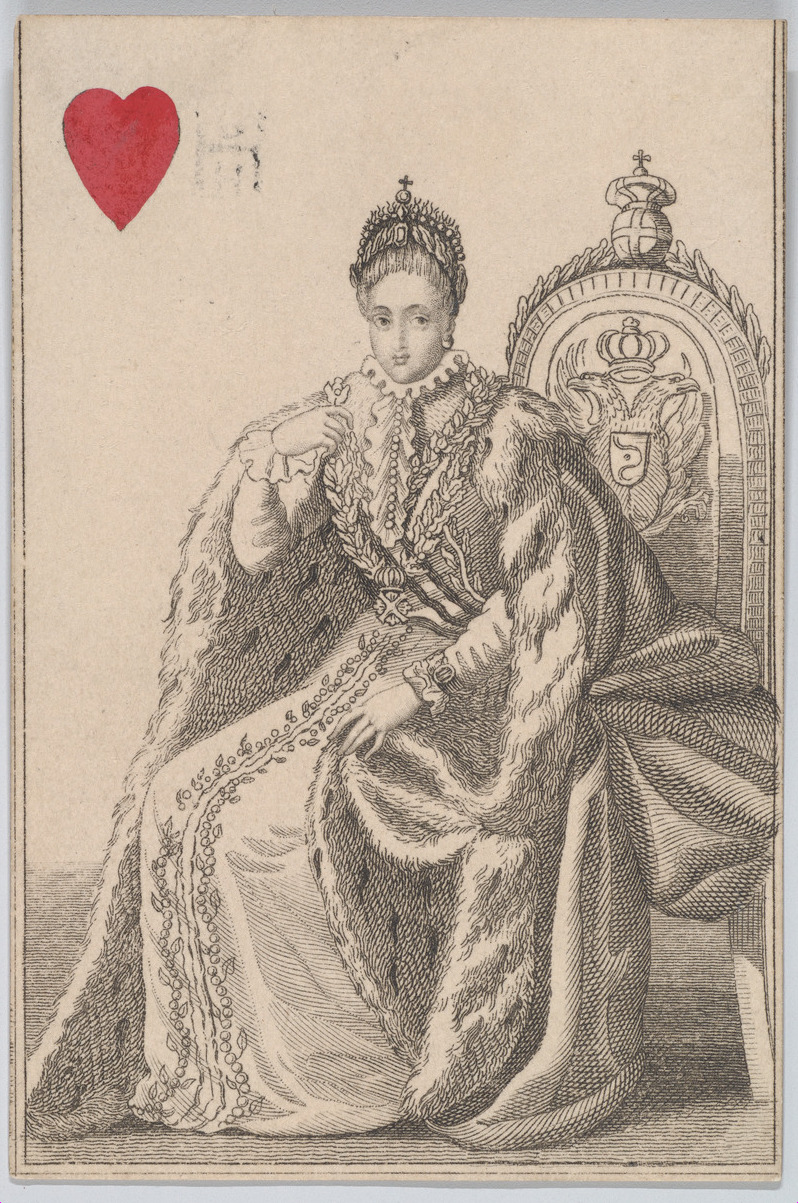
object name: print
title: Queen (Catherine 2nd from Russia), from "Court Game of Geography"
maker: william and henry rock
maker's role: publisher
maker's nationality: british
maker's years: 1821-1884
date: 1838-1855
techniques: engraving, etching, hand coloring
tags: queens,playing cards